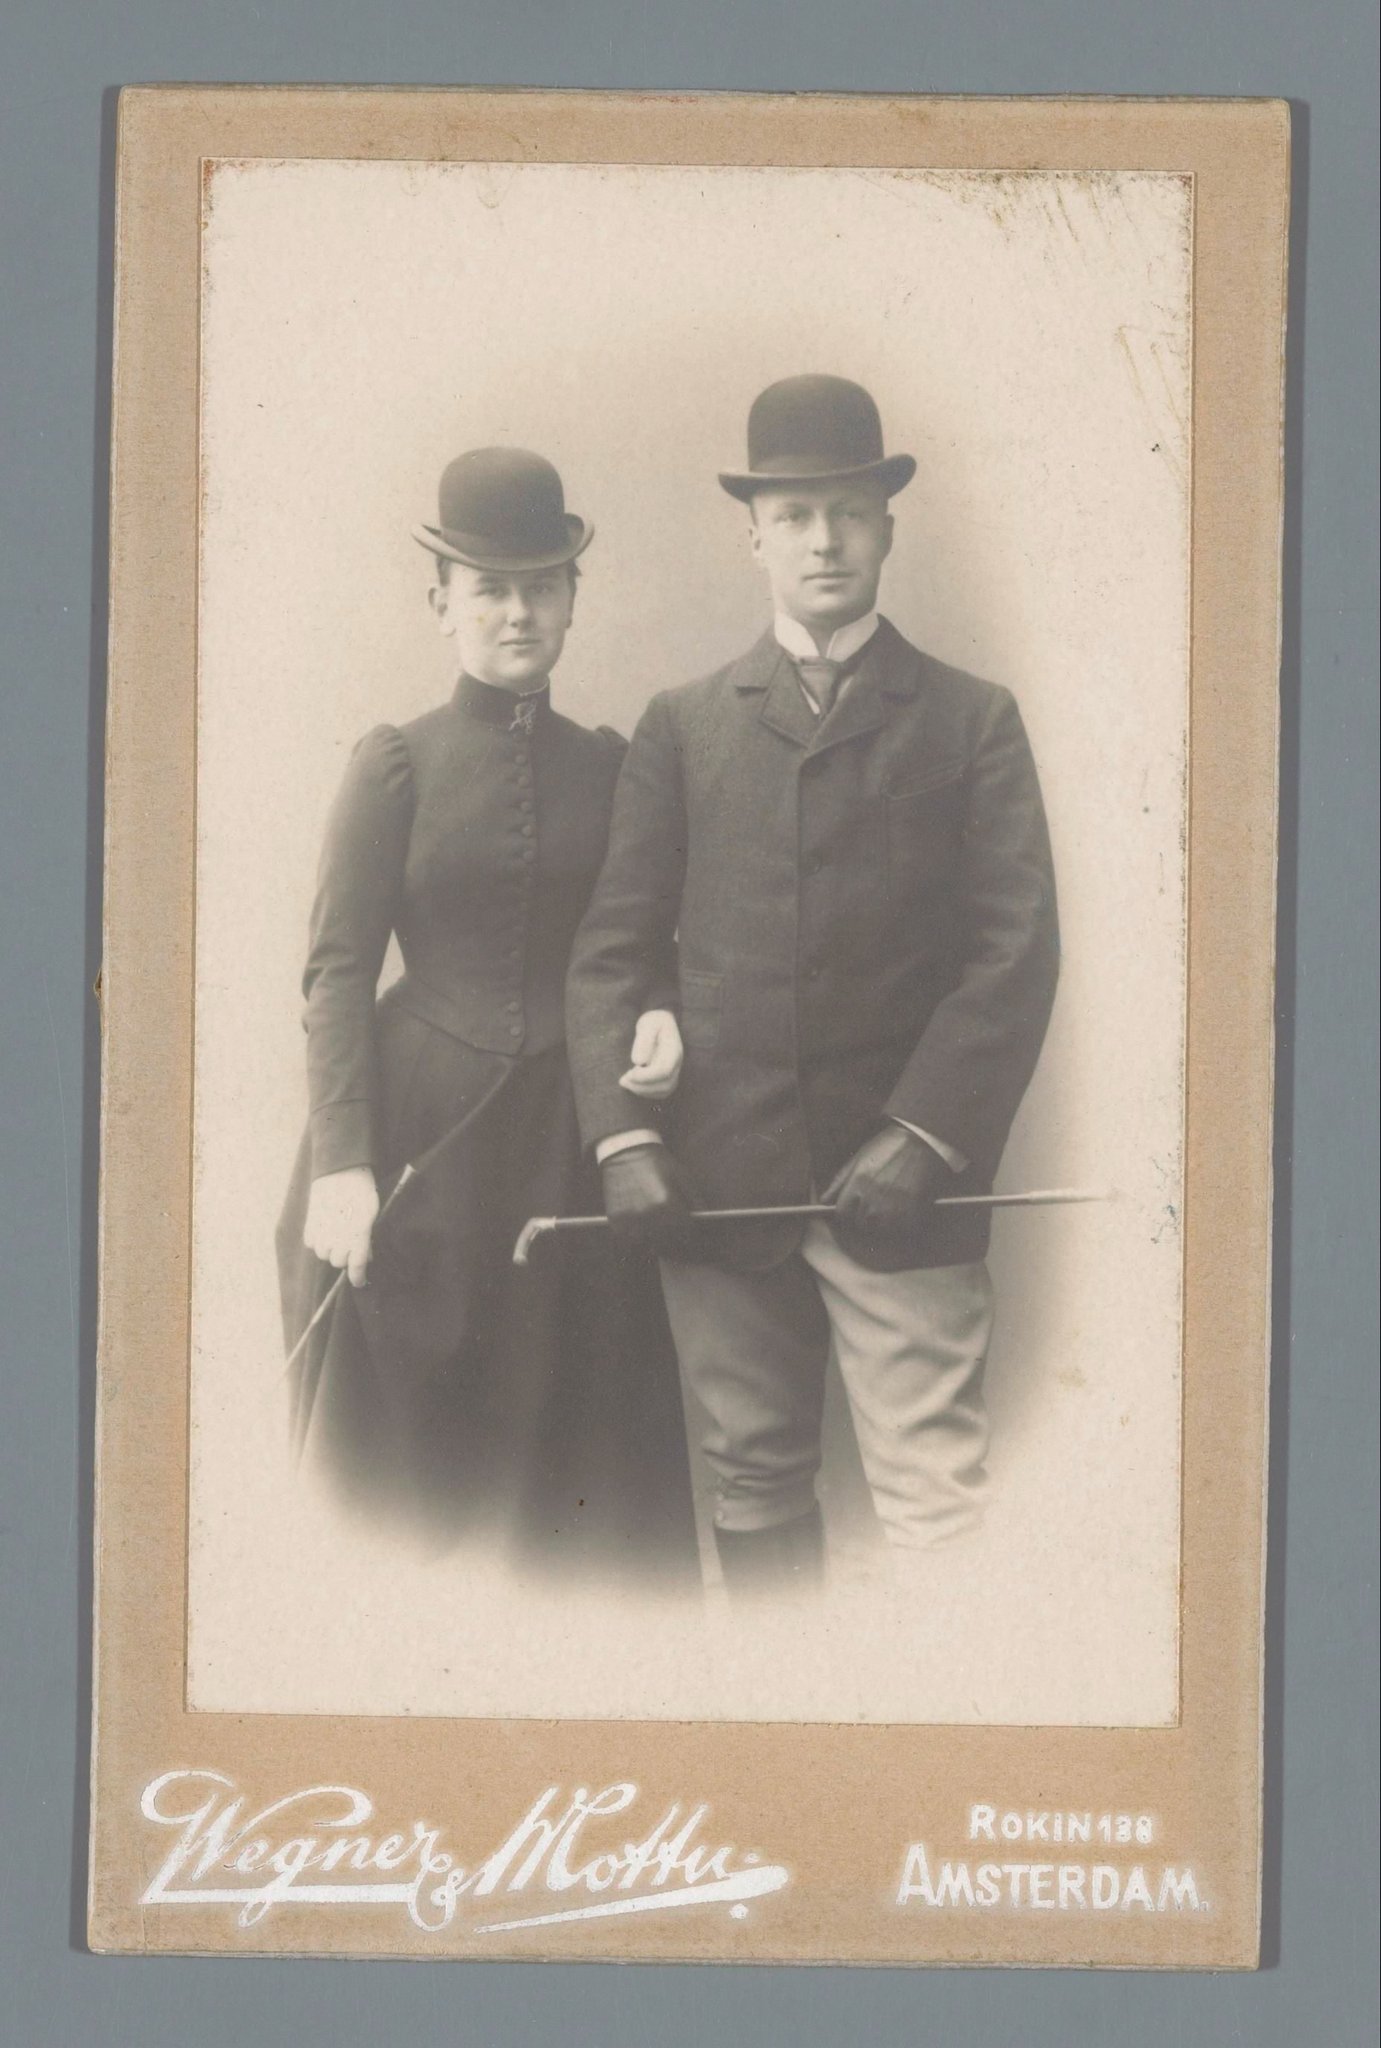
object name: photograph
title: Portret van koningin Wilhelmina en prins Hendrik in rijkleding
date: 1900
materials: cardboard, photographic support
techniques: gelatin silver print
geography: amsterdam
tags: print maker, wilhelmina of the netherlands, the hague, hendrik (prins der nederlanden (1876-1934)), riding a horse, ass, or mule; rider, horseman, prince, historical persons, queen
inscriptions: inscription: ‘Wilhelmina + Hendrik/ 1900’, inscription: ‘ALGEMEENE/ BOEK-MUZIEK EN KUNSTHANDEL/ BLANKENBERG & CO./ HOFLEVERANCIERS/ LEIDEN’, number: ‘25’